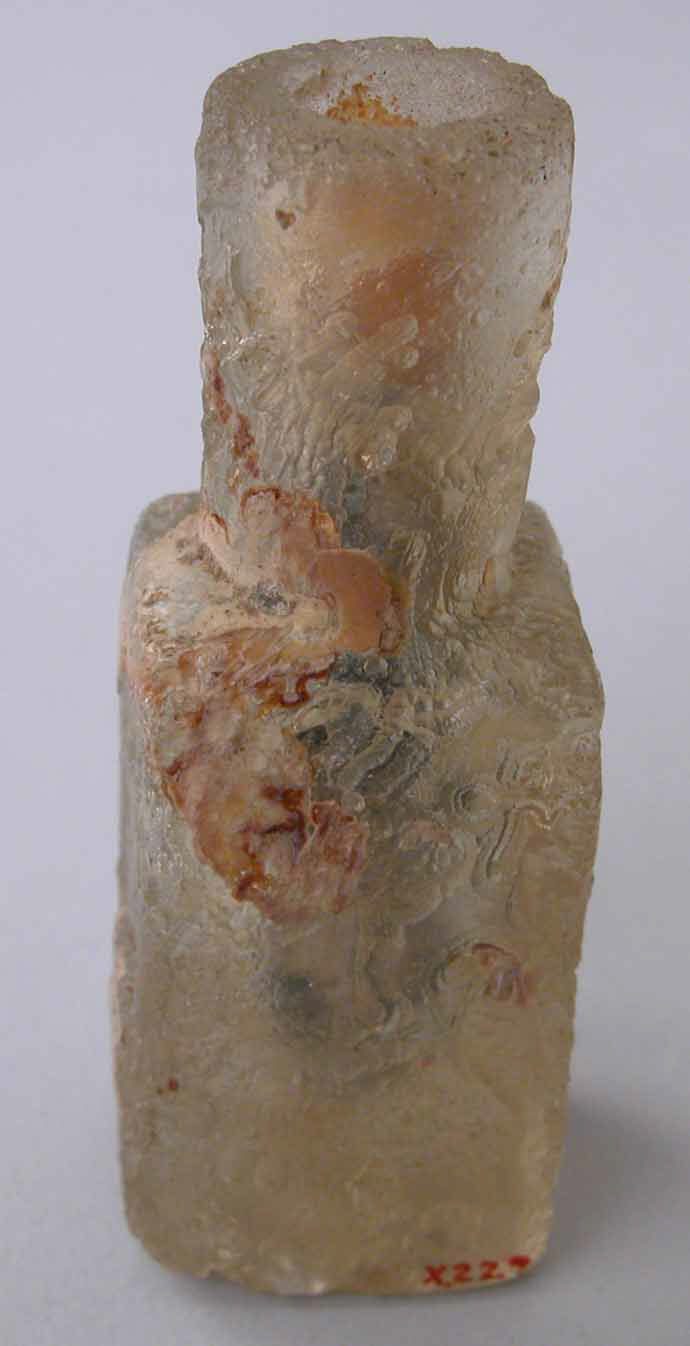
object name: bottle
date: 901-1200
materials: glass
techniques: glassblowing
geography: egypt